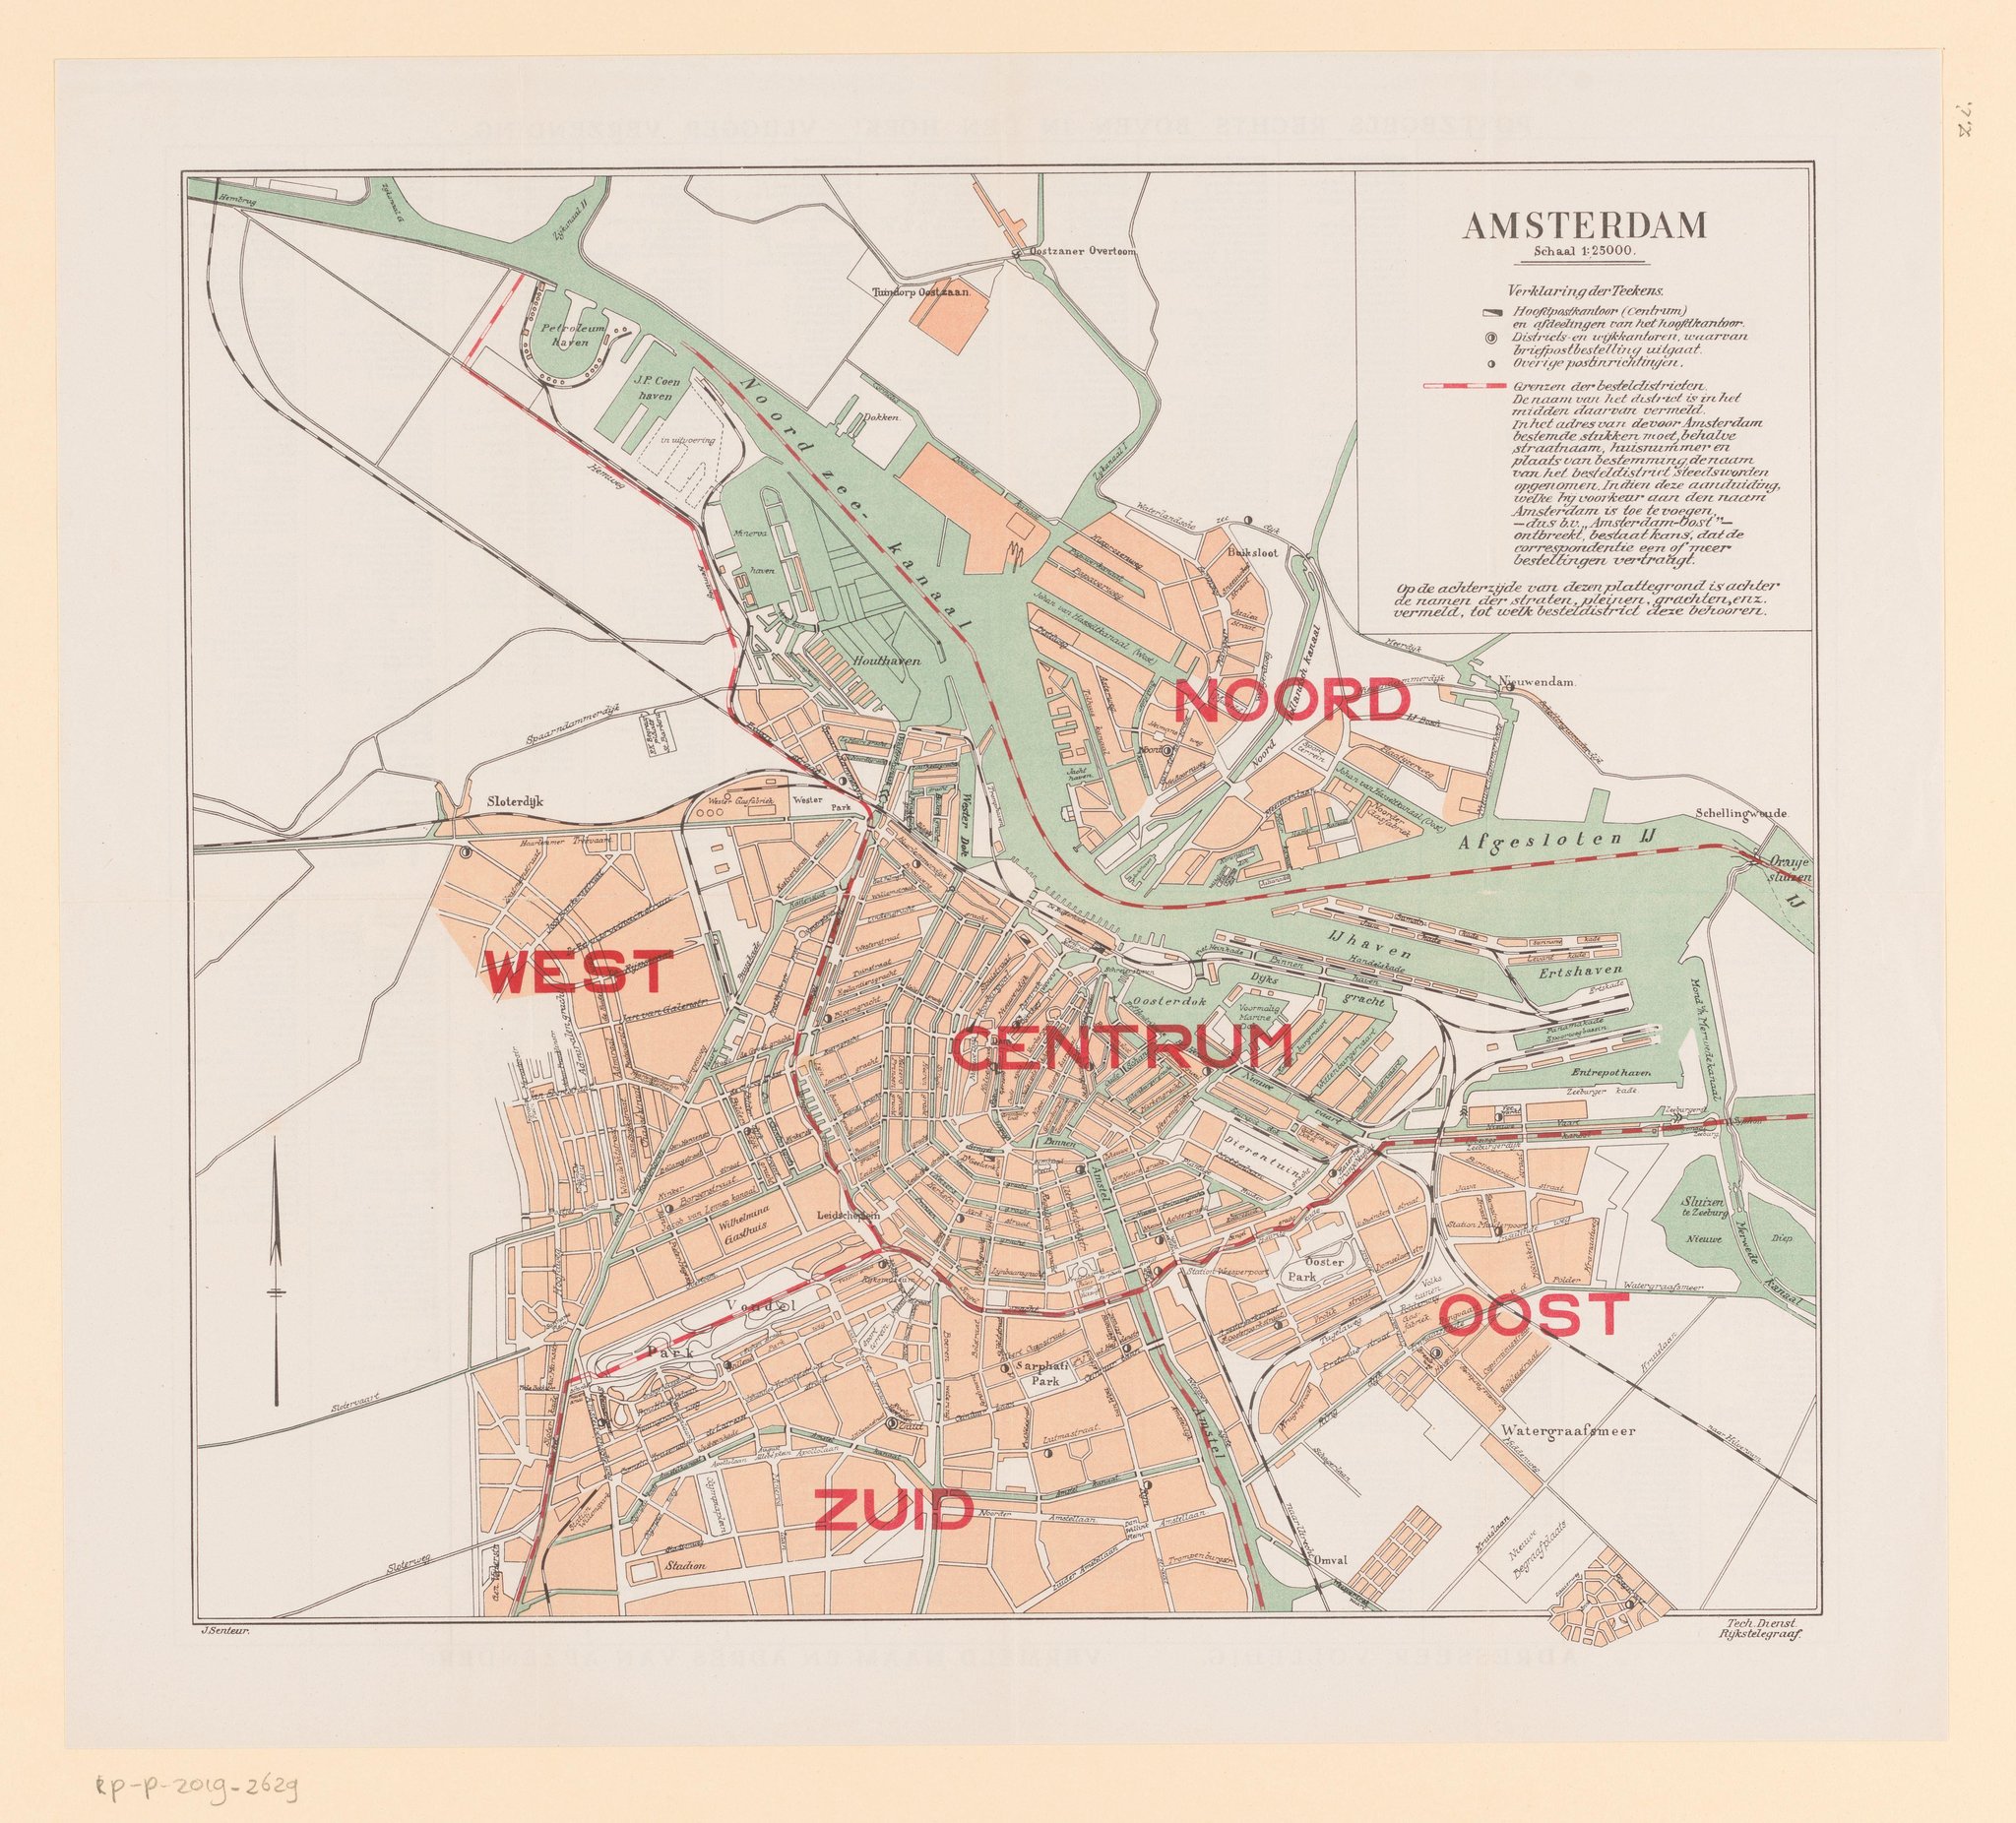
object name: area plan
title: Reproductie van een plattegrond van Amsterdam met de postkantoren en postdistricten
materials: paper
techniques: photolithography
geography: amsterdam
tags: maps of cities, amsterdam